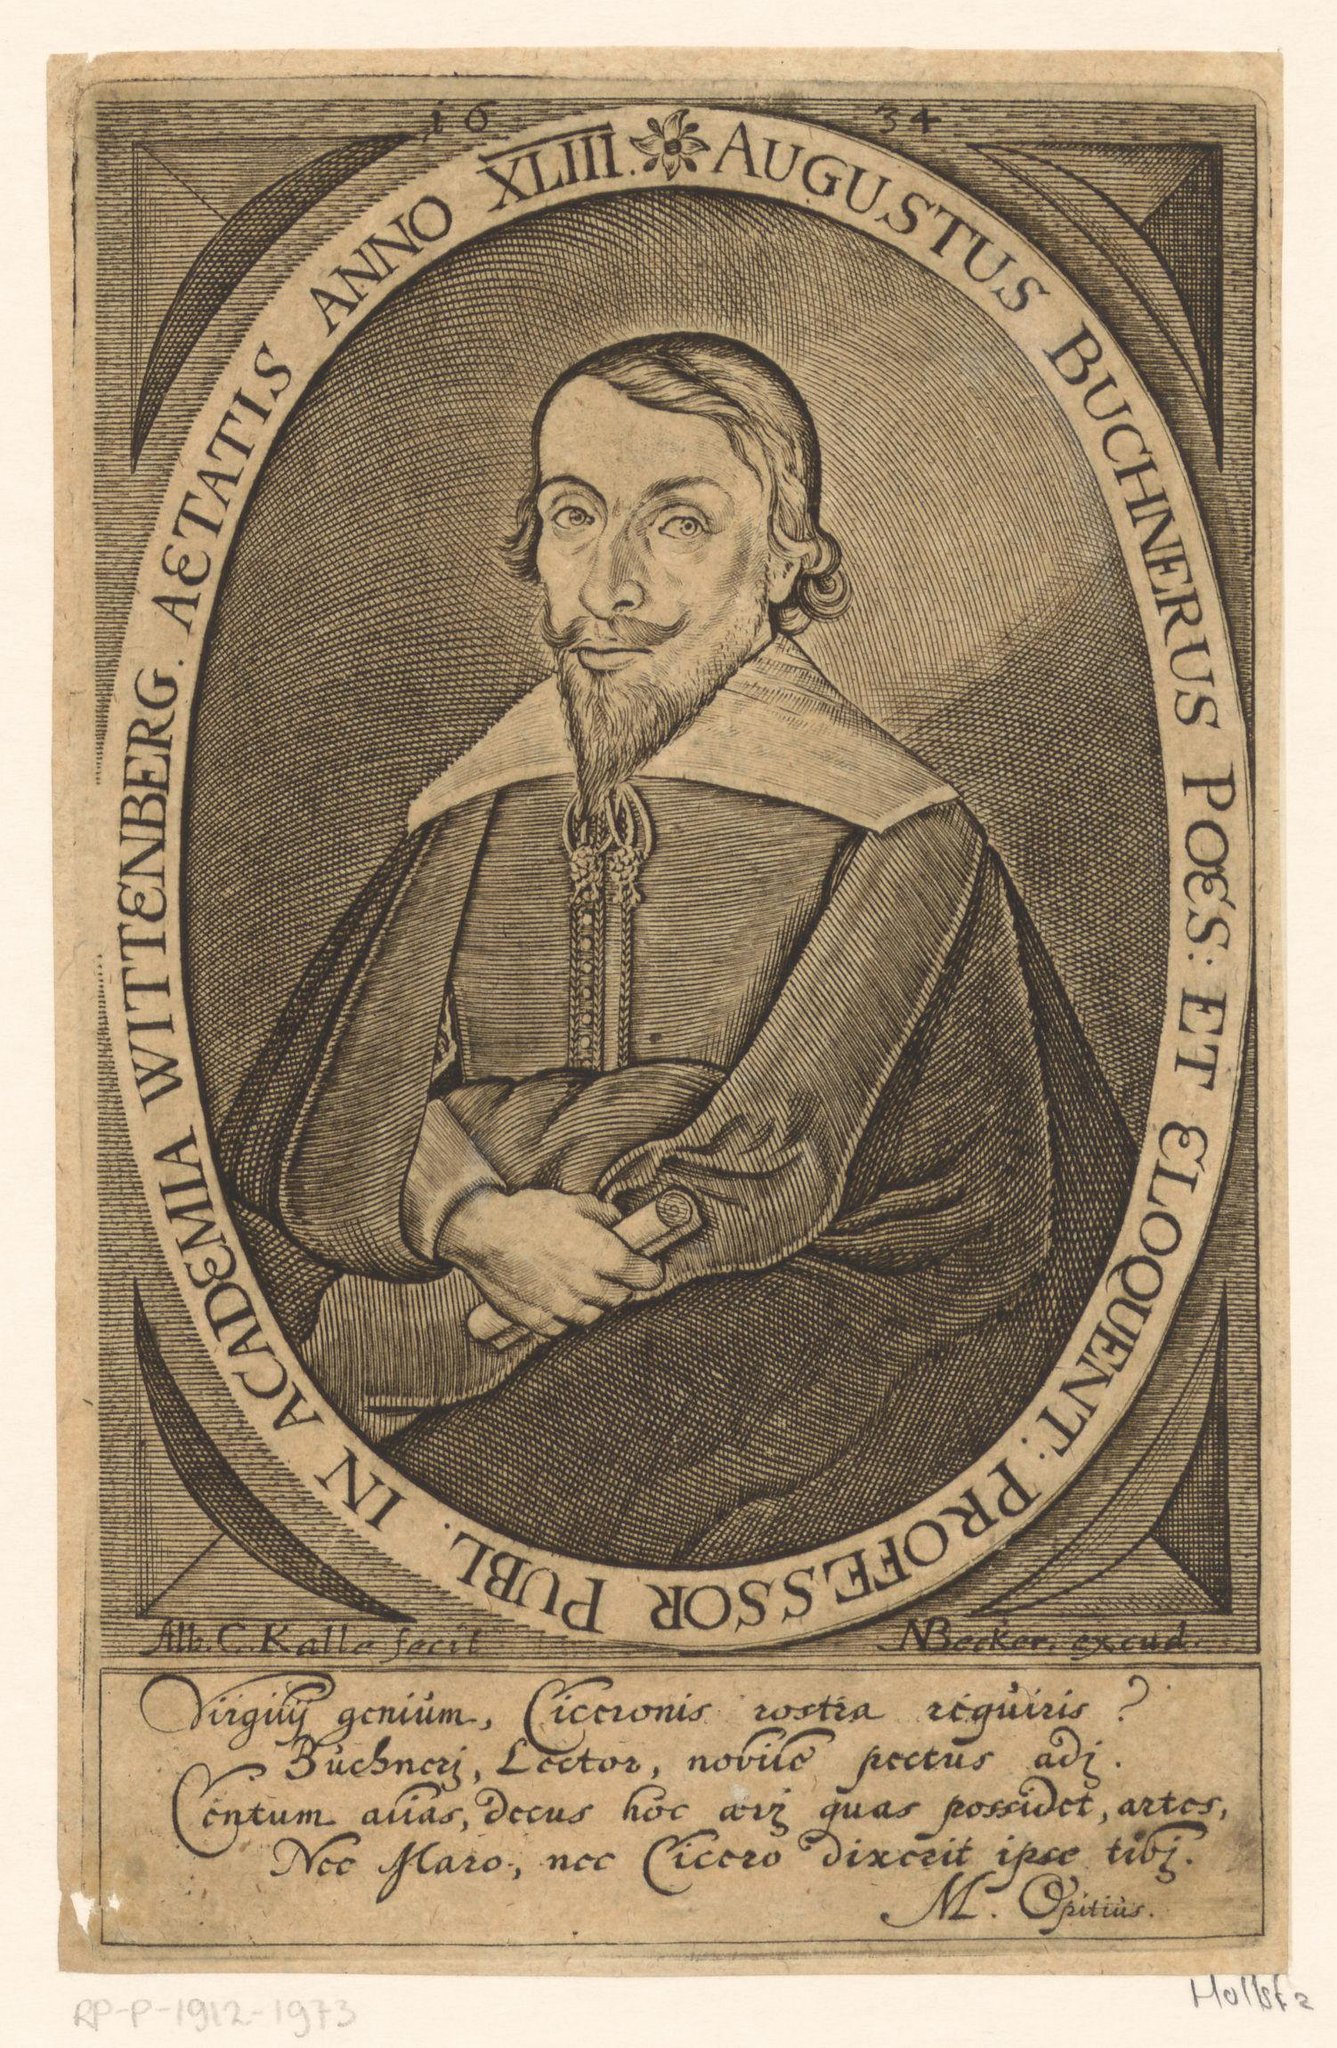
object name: print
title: Portret van August Buchner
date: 1634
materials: paper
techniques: engraving, etching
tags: august buchner, further education (+ portrait of teacher, professor), historical persons, writer, poet, author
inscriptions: collector's mark: Lugt 2228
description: Tekst in het Latijn in de omlijsting en in de marge.